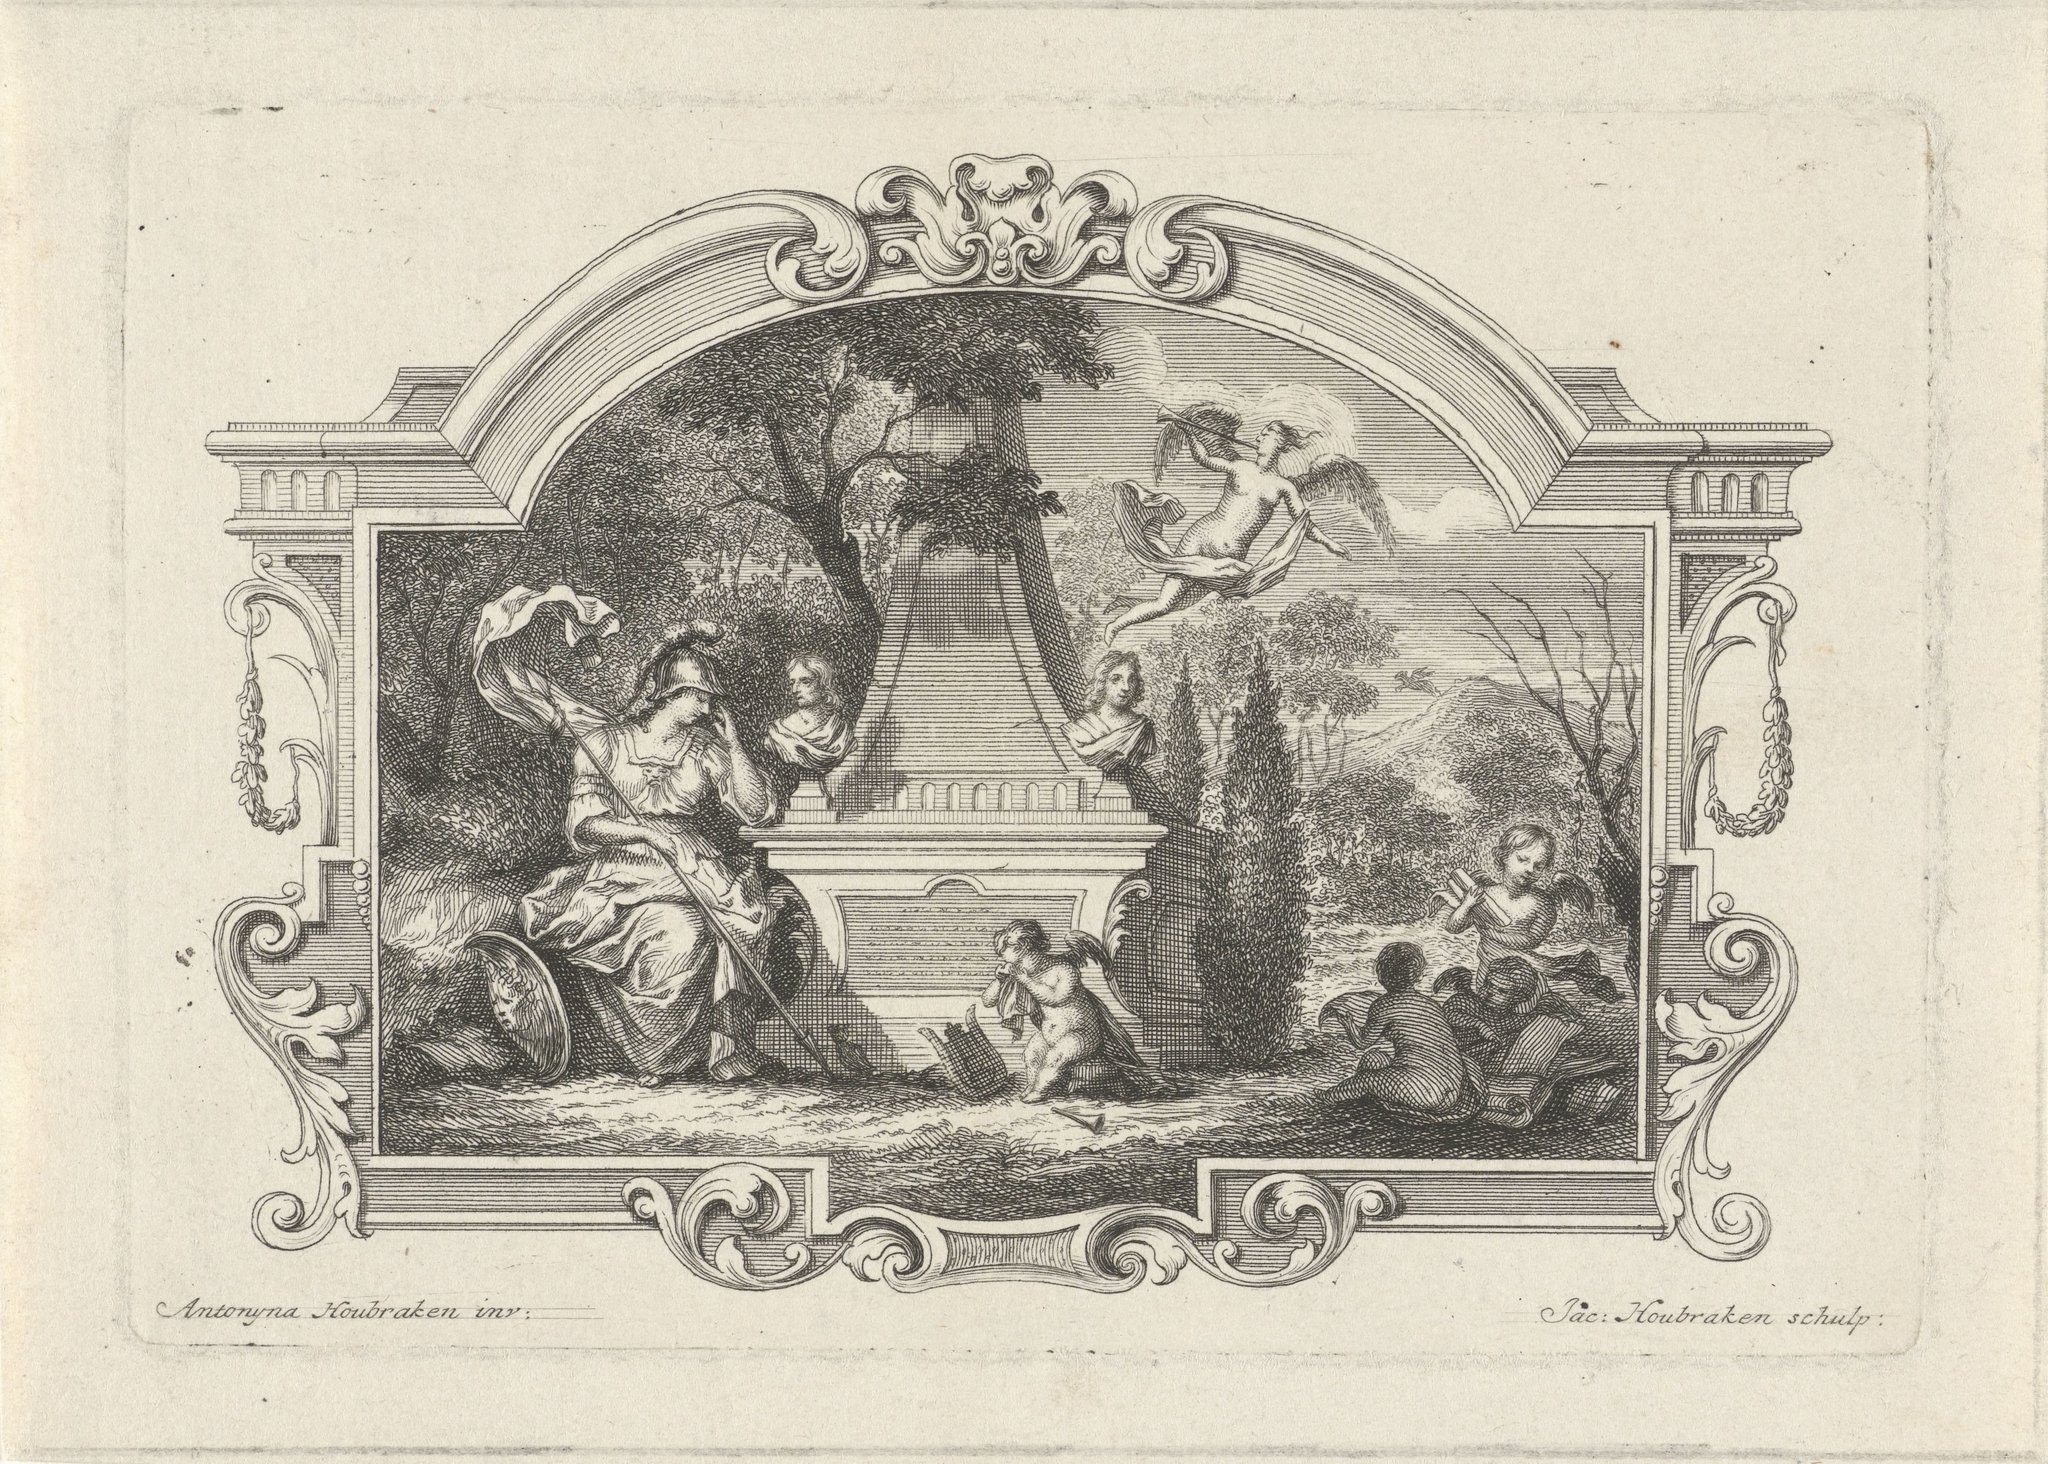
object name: print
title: Minerva en putti treurend bij een graftombe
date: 1708-1780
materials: paper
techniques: etching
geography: amsterdam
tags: mourning the dead, specific aspects, allegorical aspects of minerva; minerva as patroness, trireme, galley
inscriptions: collector's mark: Lugt 240